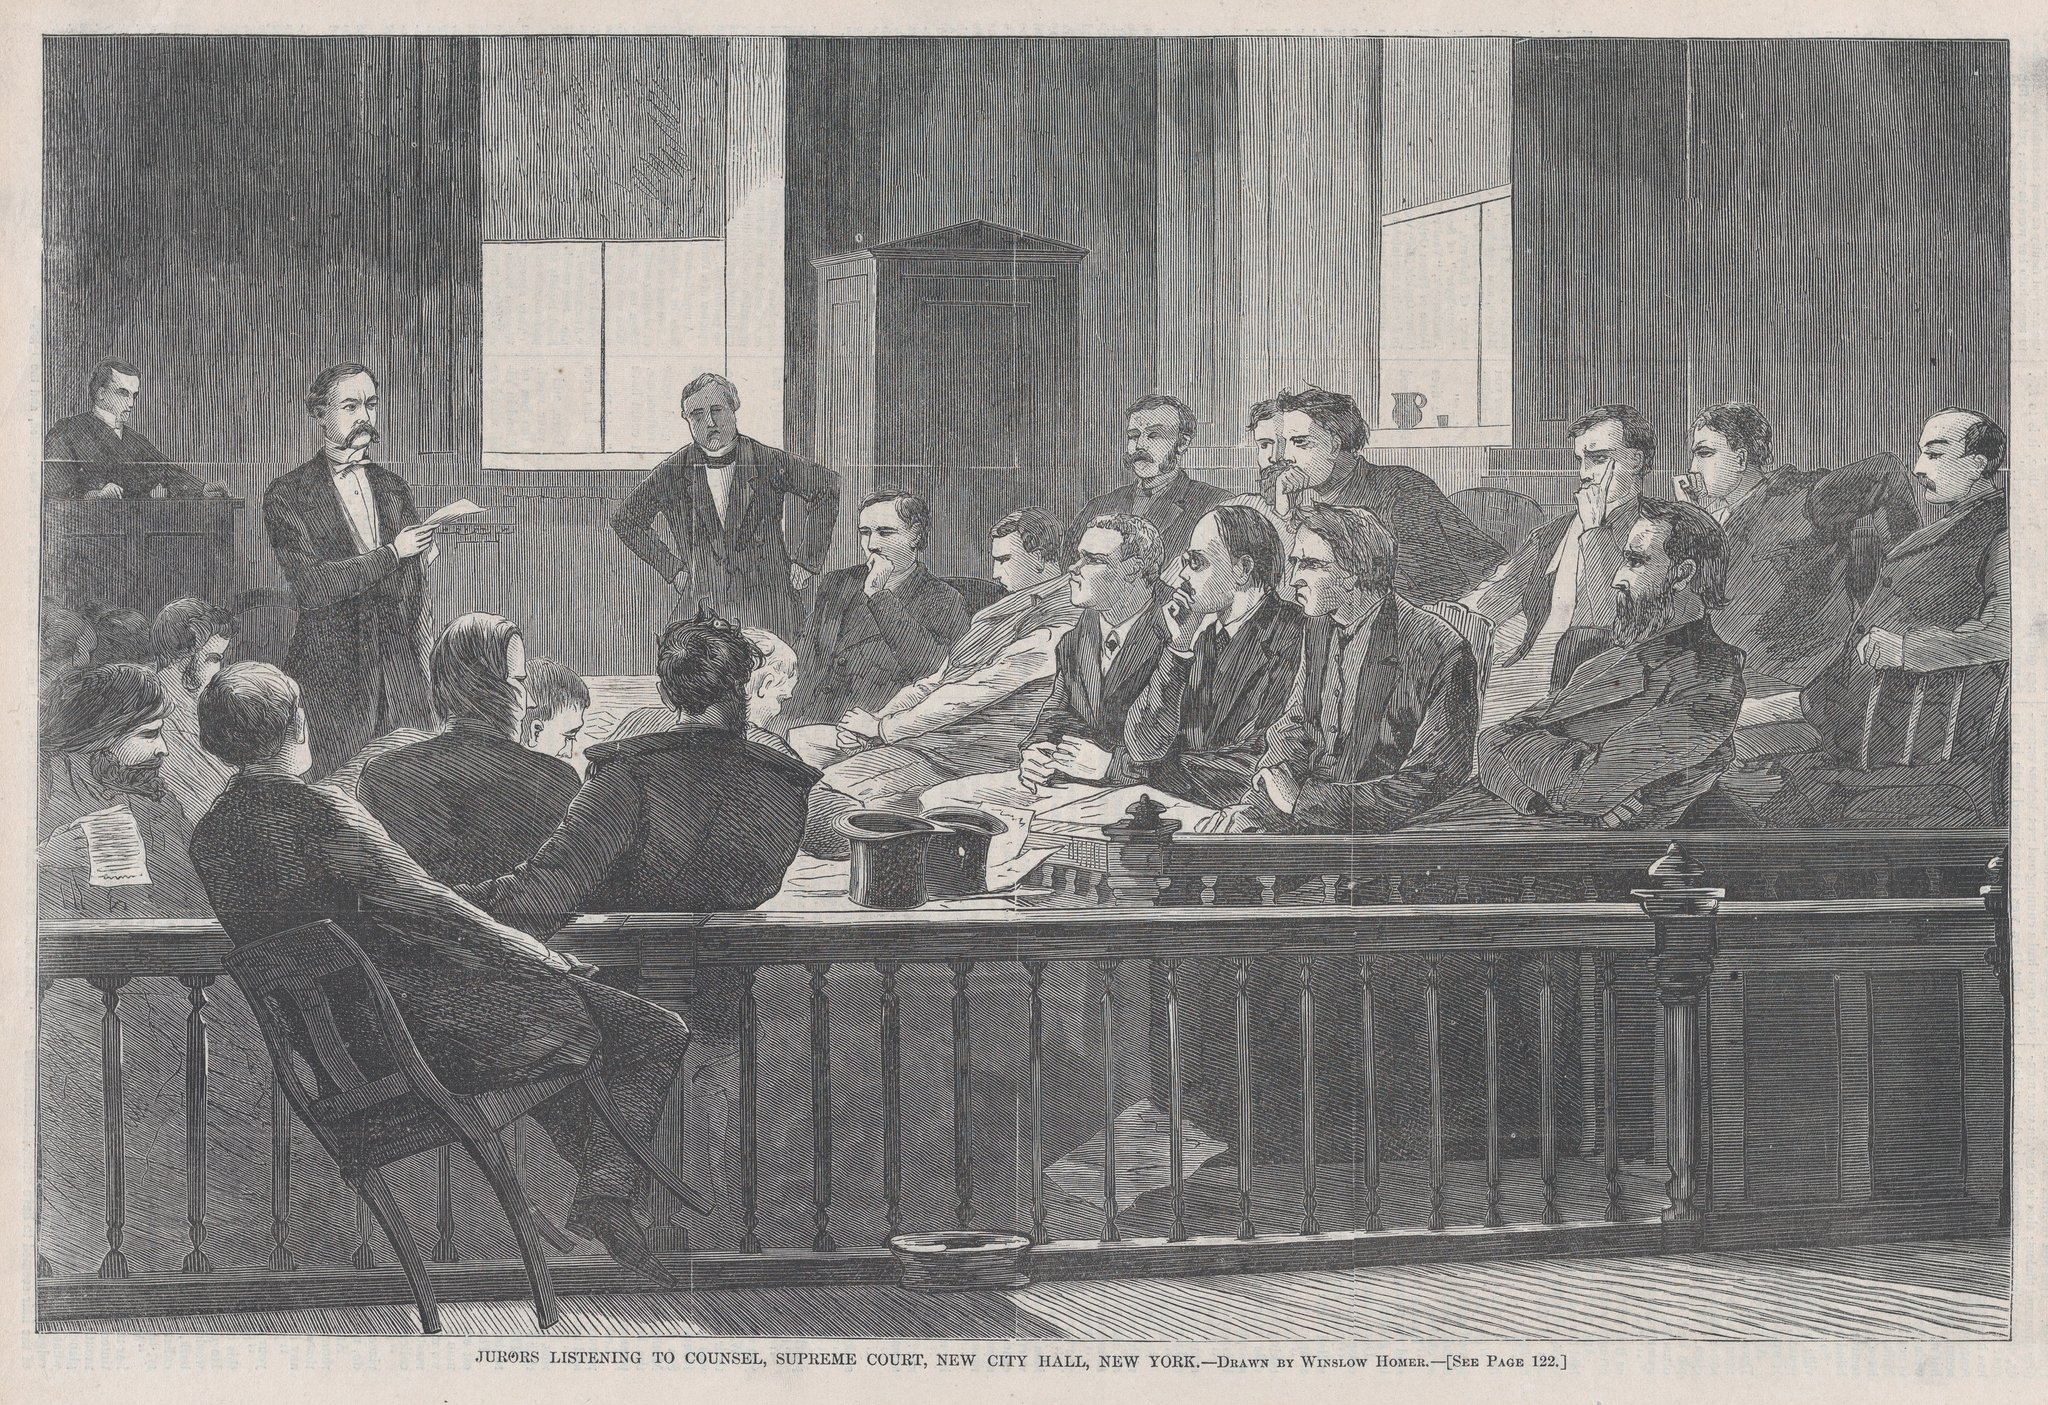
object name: print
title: Jurors Listening to Counsel, Supreme Court, New York City Hall, New York (from "Harper's Weekly," Vol. XIII)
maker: winslow homer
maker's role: artist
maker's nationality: american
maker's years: 1836-1910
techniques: engraving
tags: men,law